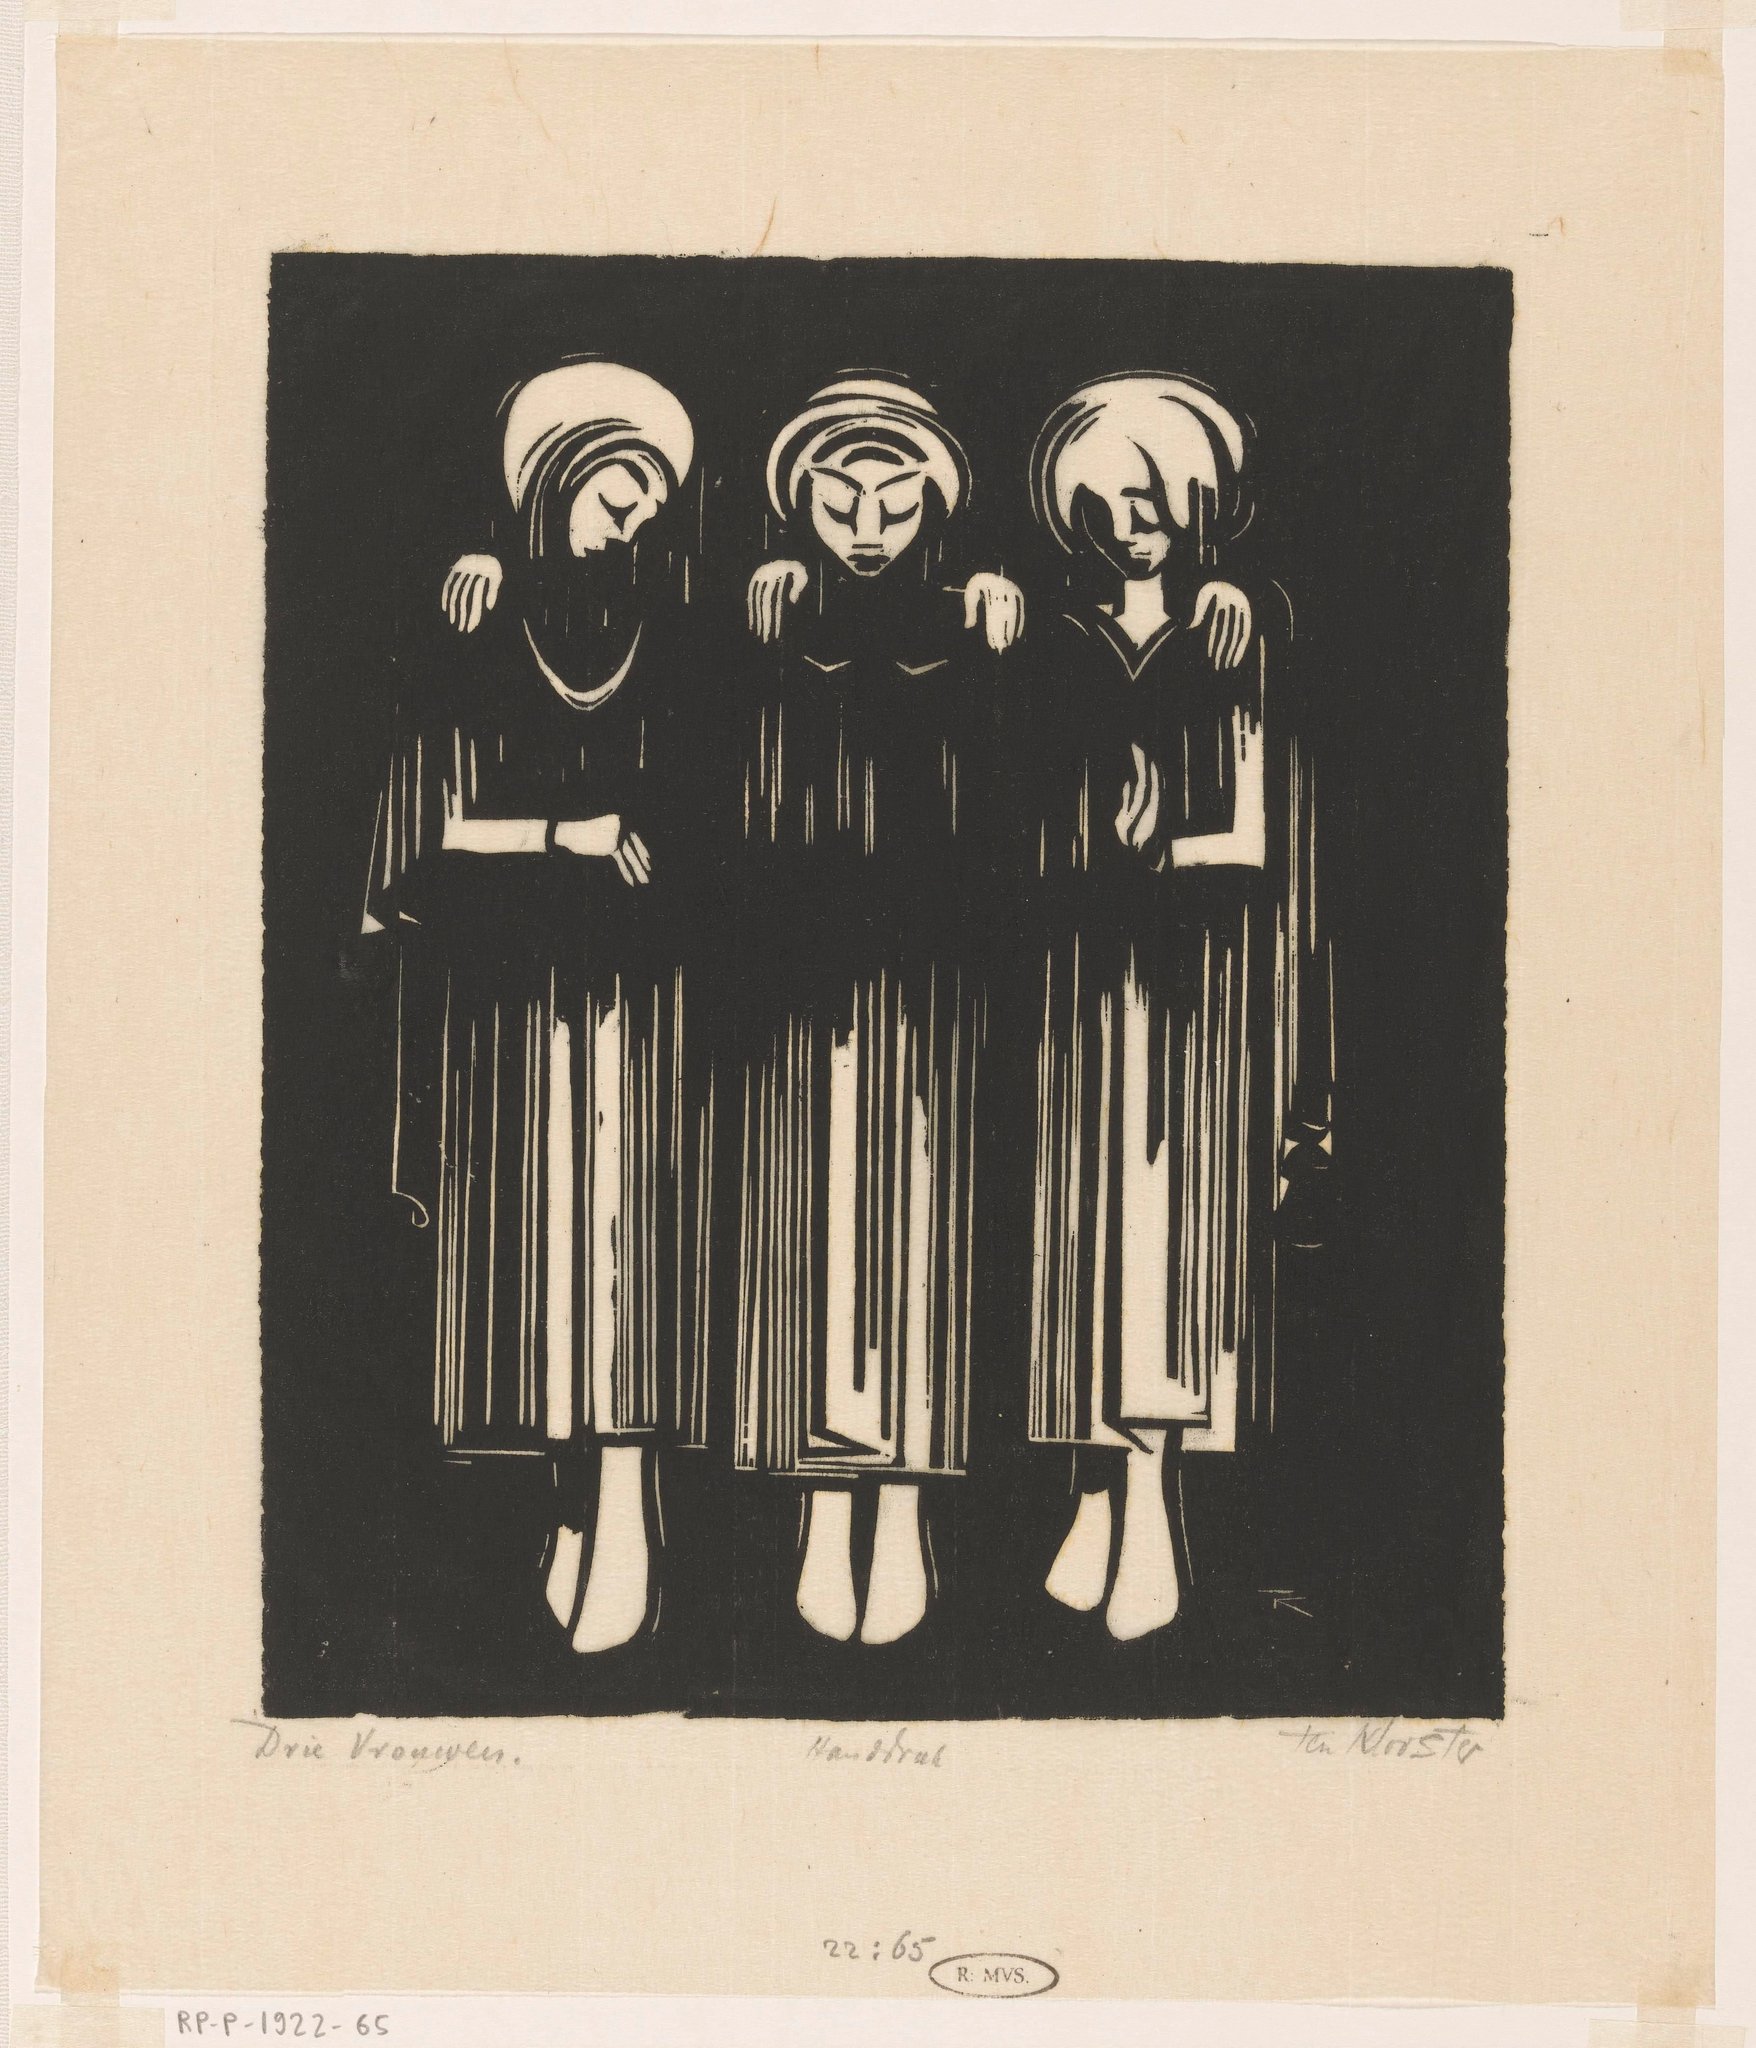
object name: print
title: Drie vrouwen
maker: johannes frederik engelbert ten klooster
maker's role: draughtsman, print maker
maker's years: 1873-1940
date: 1921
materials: paper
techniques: woodcut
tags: standing figure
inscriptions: collector's mark: Lugt 2228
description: Drie vrouwen die elkaar om de schouder vasthouden.